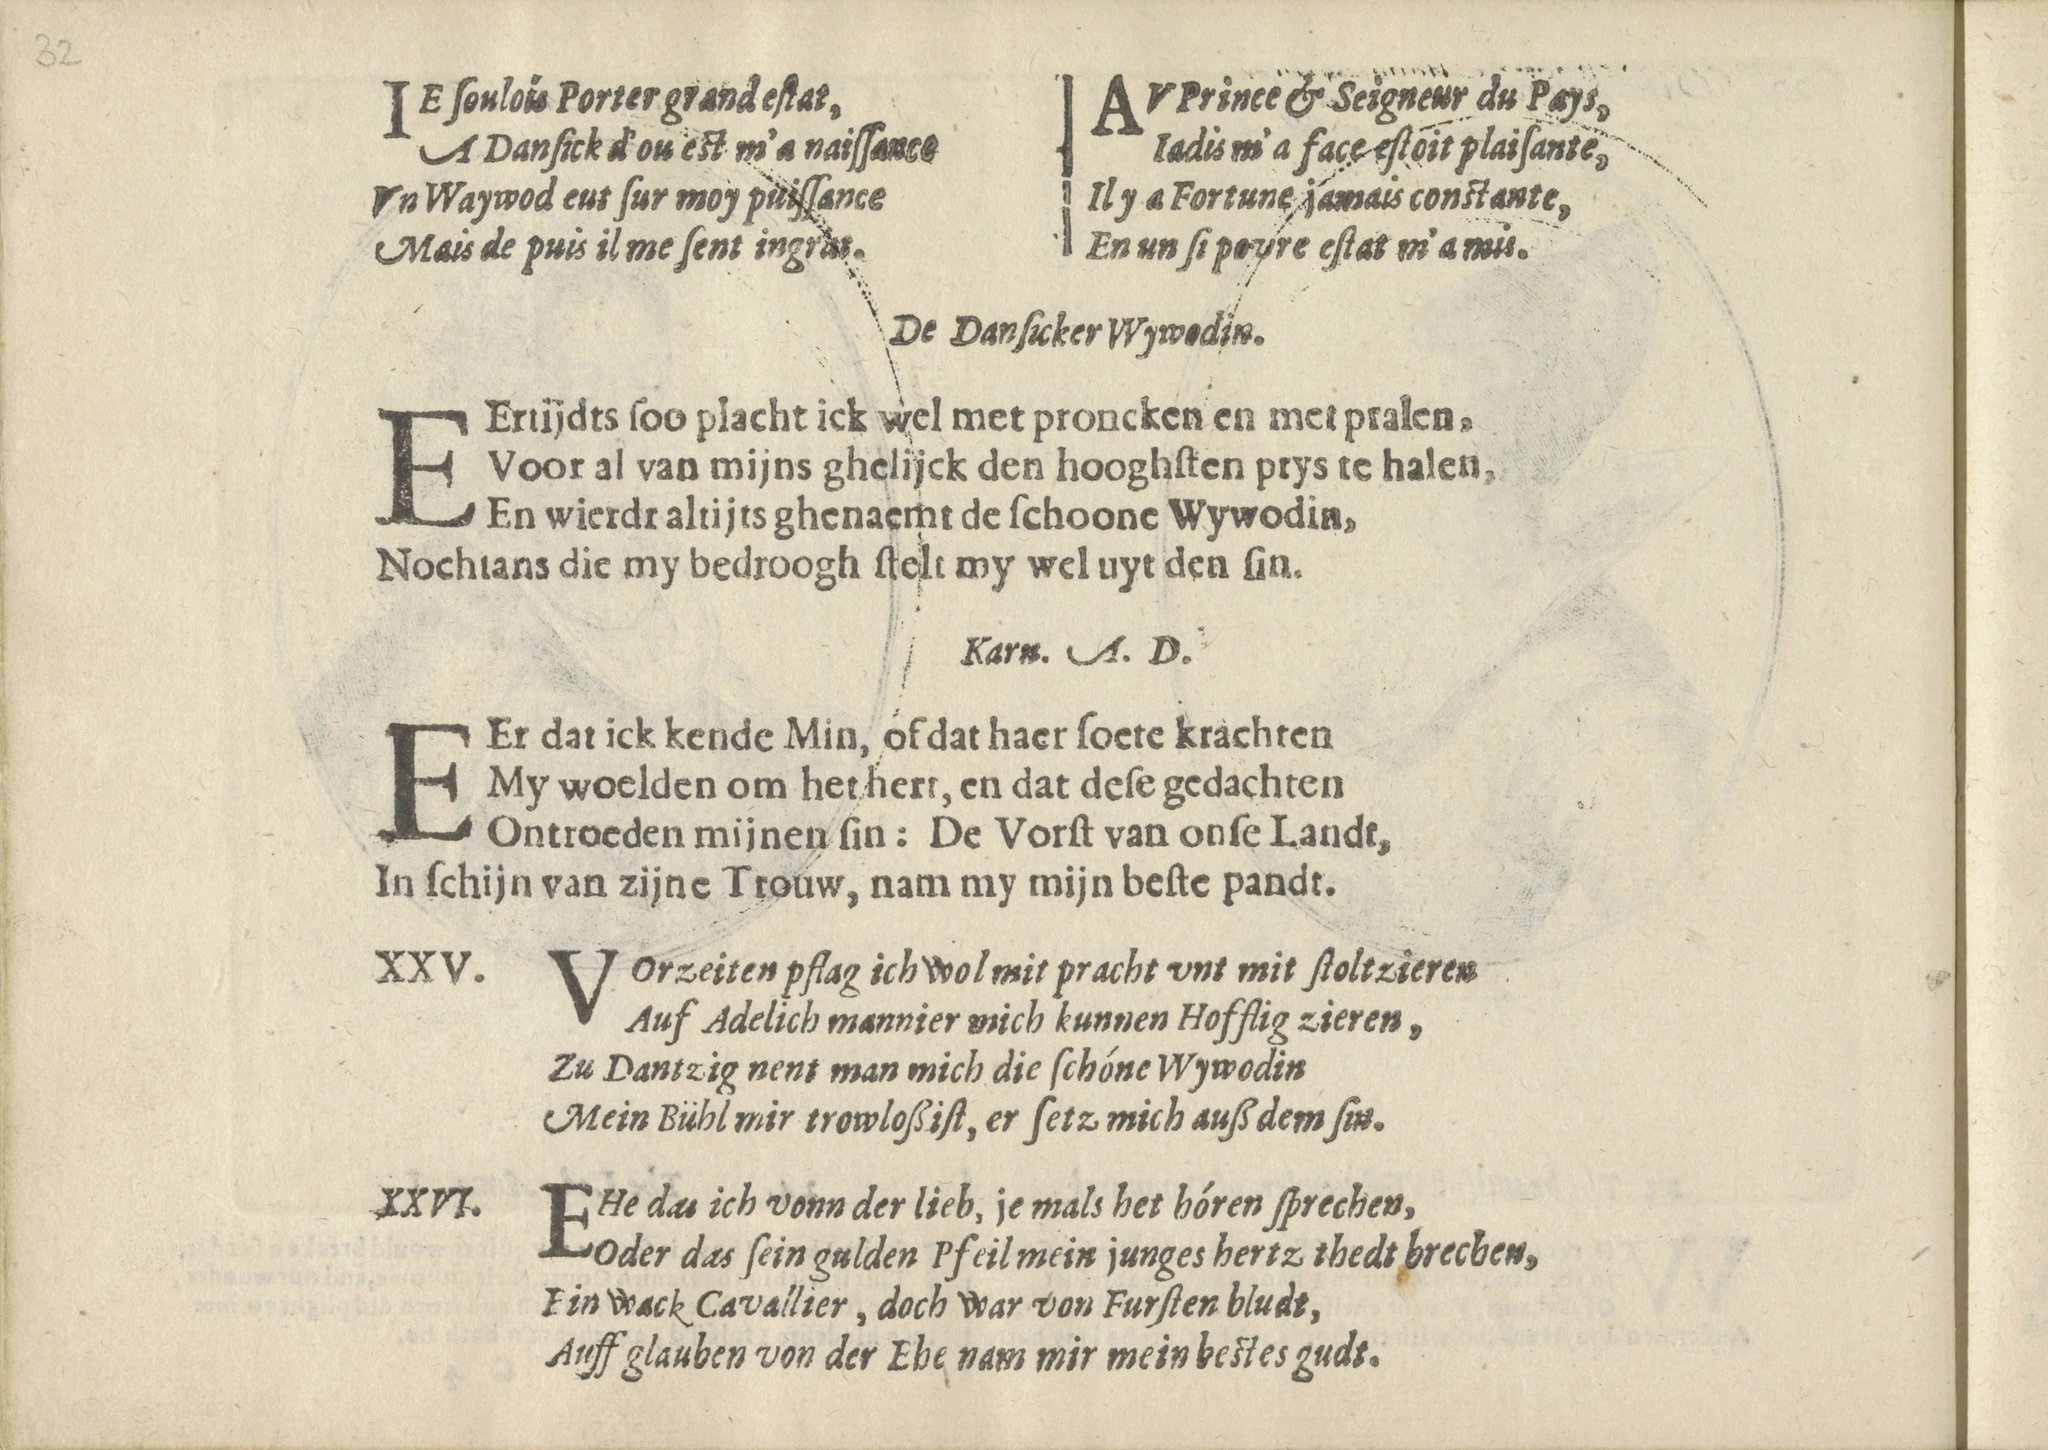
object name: text sheet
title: Kwatrijnen bij de portretten van de courtisanes genaamd Deense Wywodin en Karne A.D.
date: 1635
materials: paper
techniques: letterpress printing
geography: utrecht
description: Drie keer twee kwatrijnen in het Frans, Nederlands en Duits bij de portretten van de courtisanes genaamd Deense Wywodin en Karne A.D. Het blad maakt deel uit van een album.